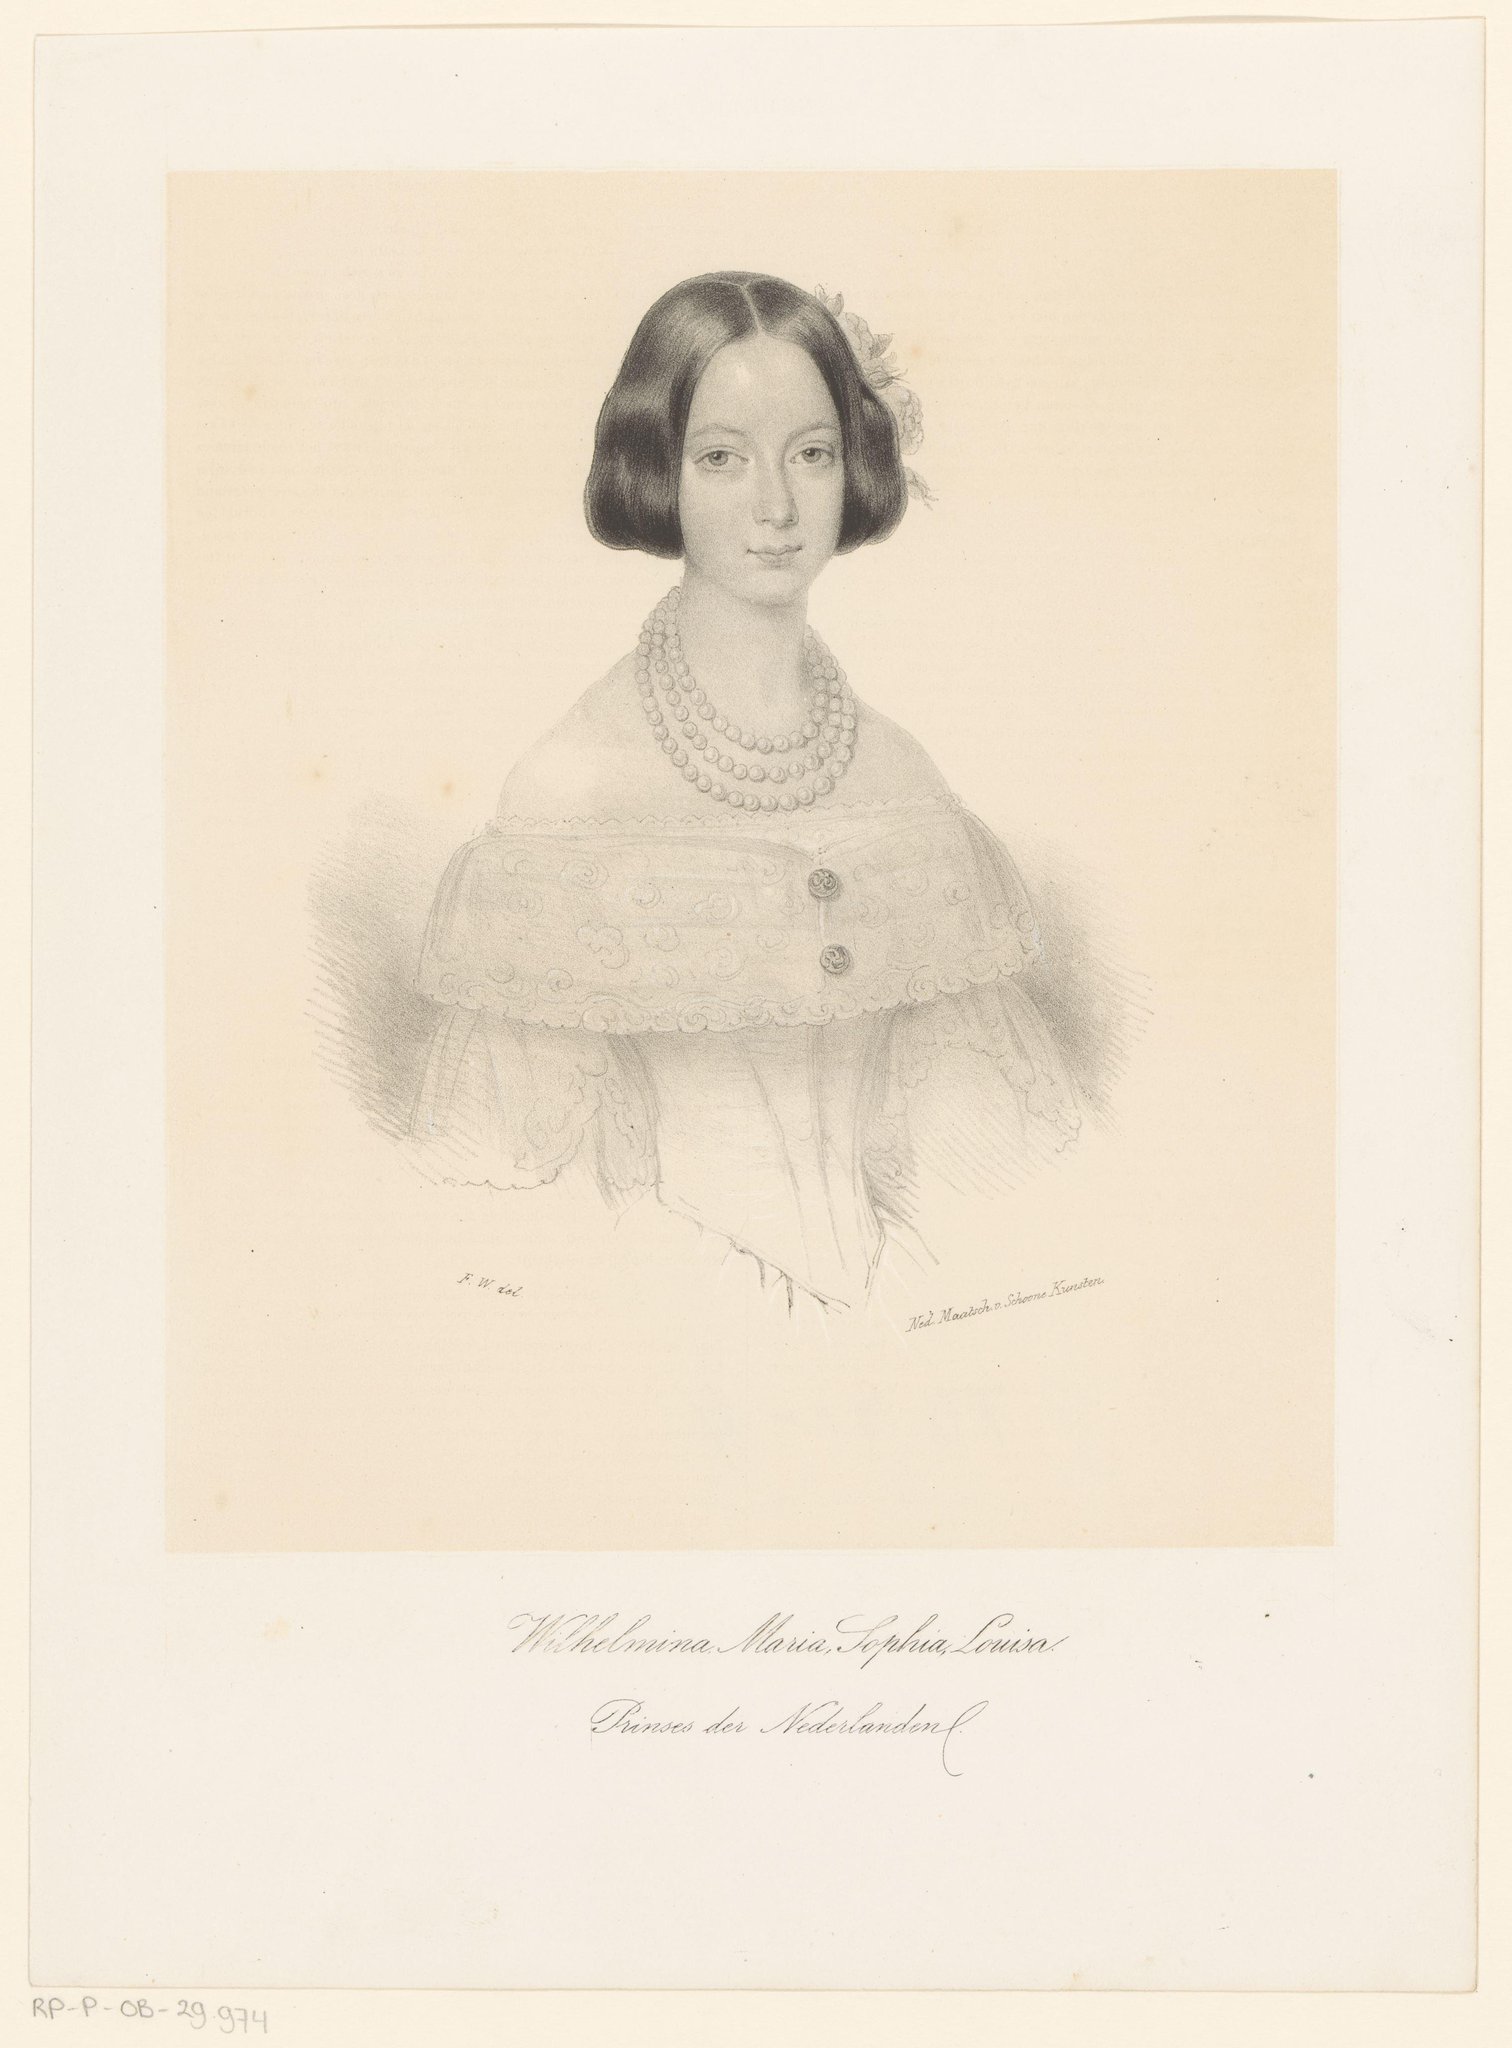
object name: print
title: Portret van Sophie, prinses der Nederlanden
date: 1840-1843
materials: paper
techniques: tone lithography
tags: the hague, historical persons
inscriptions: collector's mark: Lugt 2228